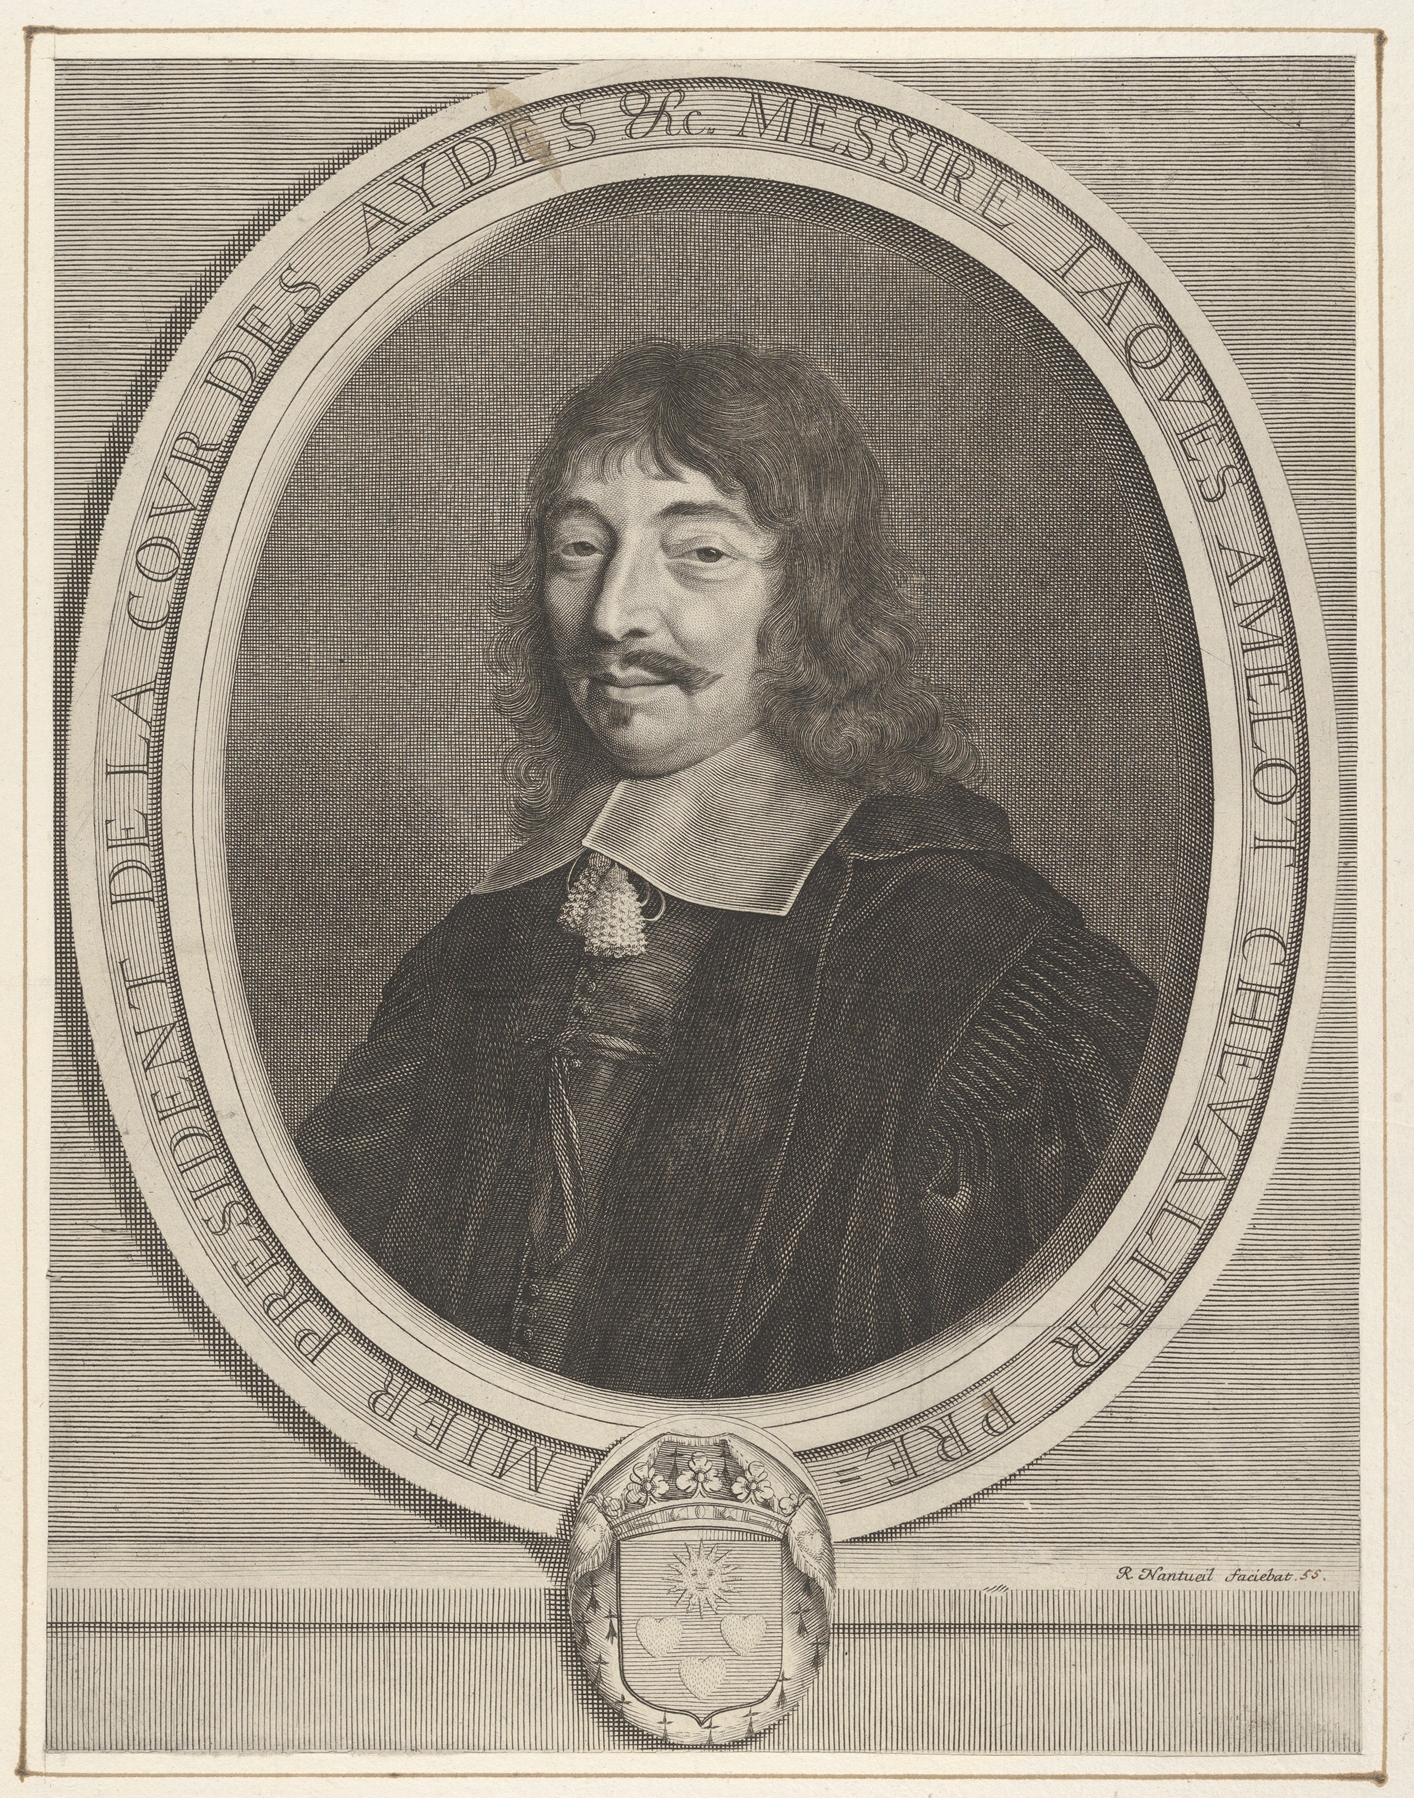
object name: print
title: Jacques Amelot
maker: robert nanteuil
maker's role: artist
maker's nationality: french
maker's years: 1623-1678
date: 1655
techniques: engraving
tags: men,portraits,coat of arms